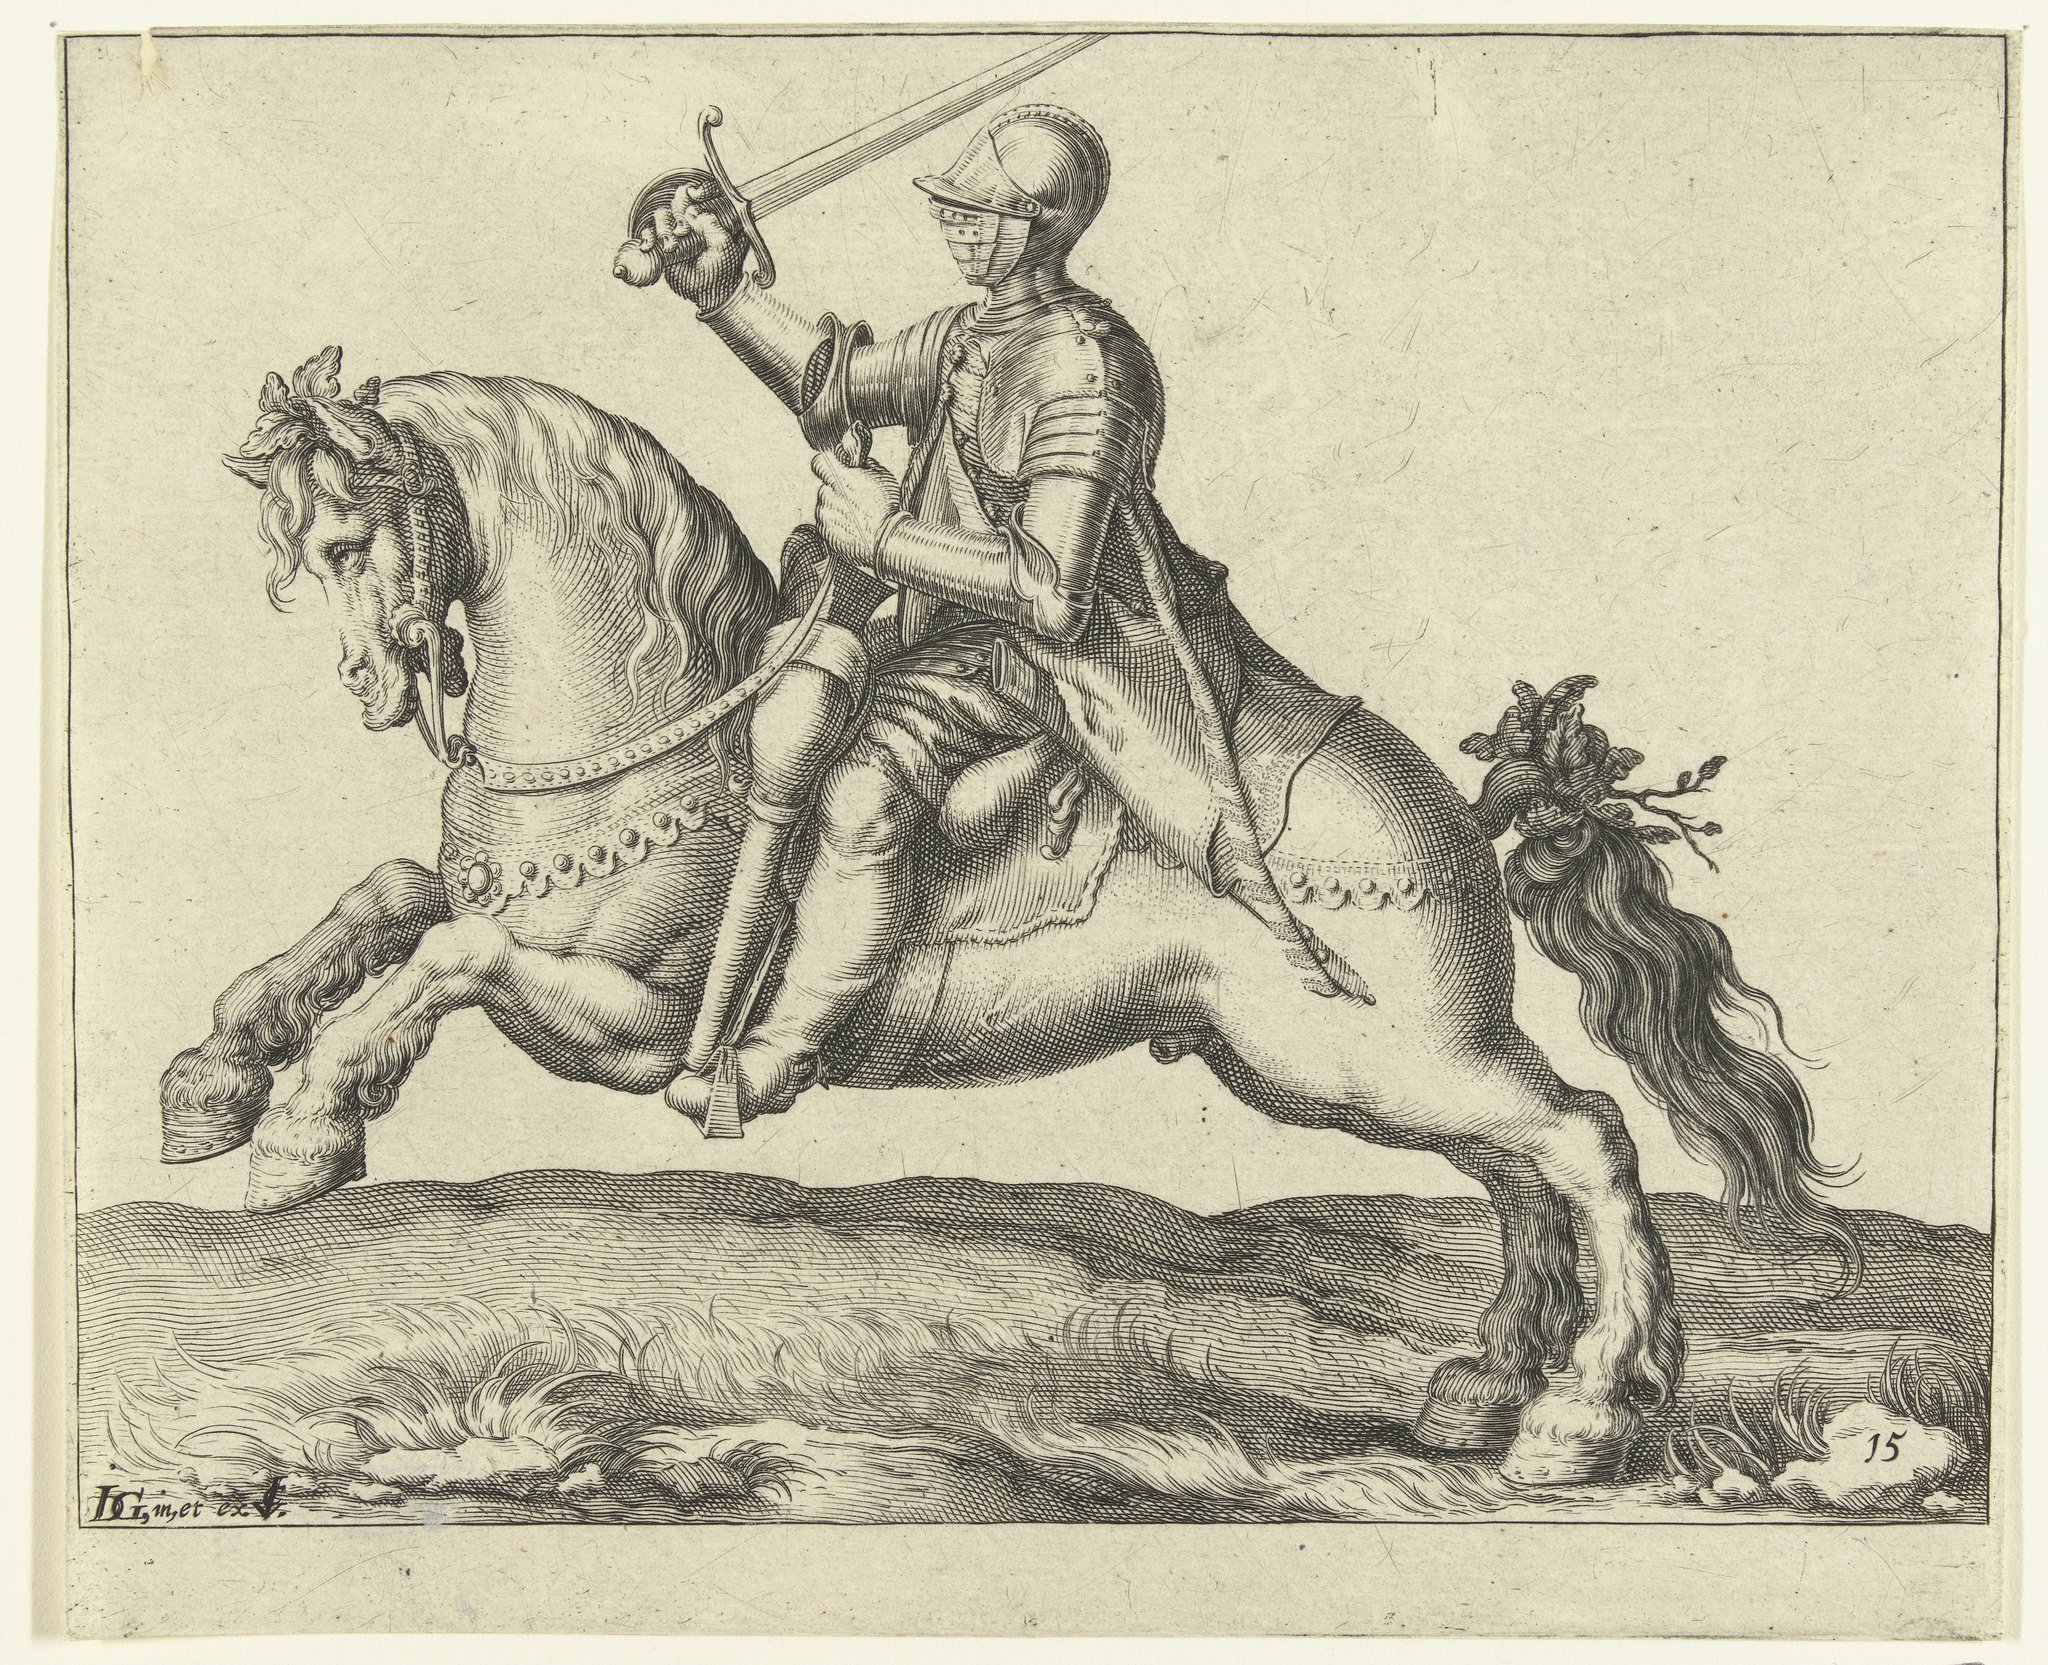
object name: print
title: Ruiter met geheven zwaard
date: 1599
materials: paper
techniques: engraving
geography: netherlands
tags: hacking and thrusting weapons: sword, warfare; military affairs (+ cavalry, horsemen)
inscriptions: collector's mark: Lugt 2228a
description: Een geharnaste man te paard met geheven zwaard, naar links rijdend. Deze prent is onderdeel van een serie van 22 genummerde prenten: een titelprent, 20 prenten waarop één of enkele verschillende typen (meest geharnaste) ruiters zijn weergegeven, en een prent met een ruitergevecht.